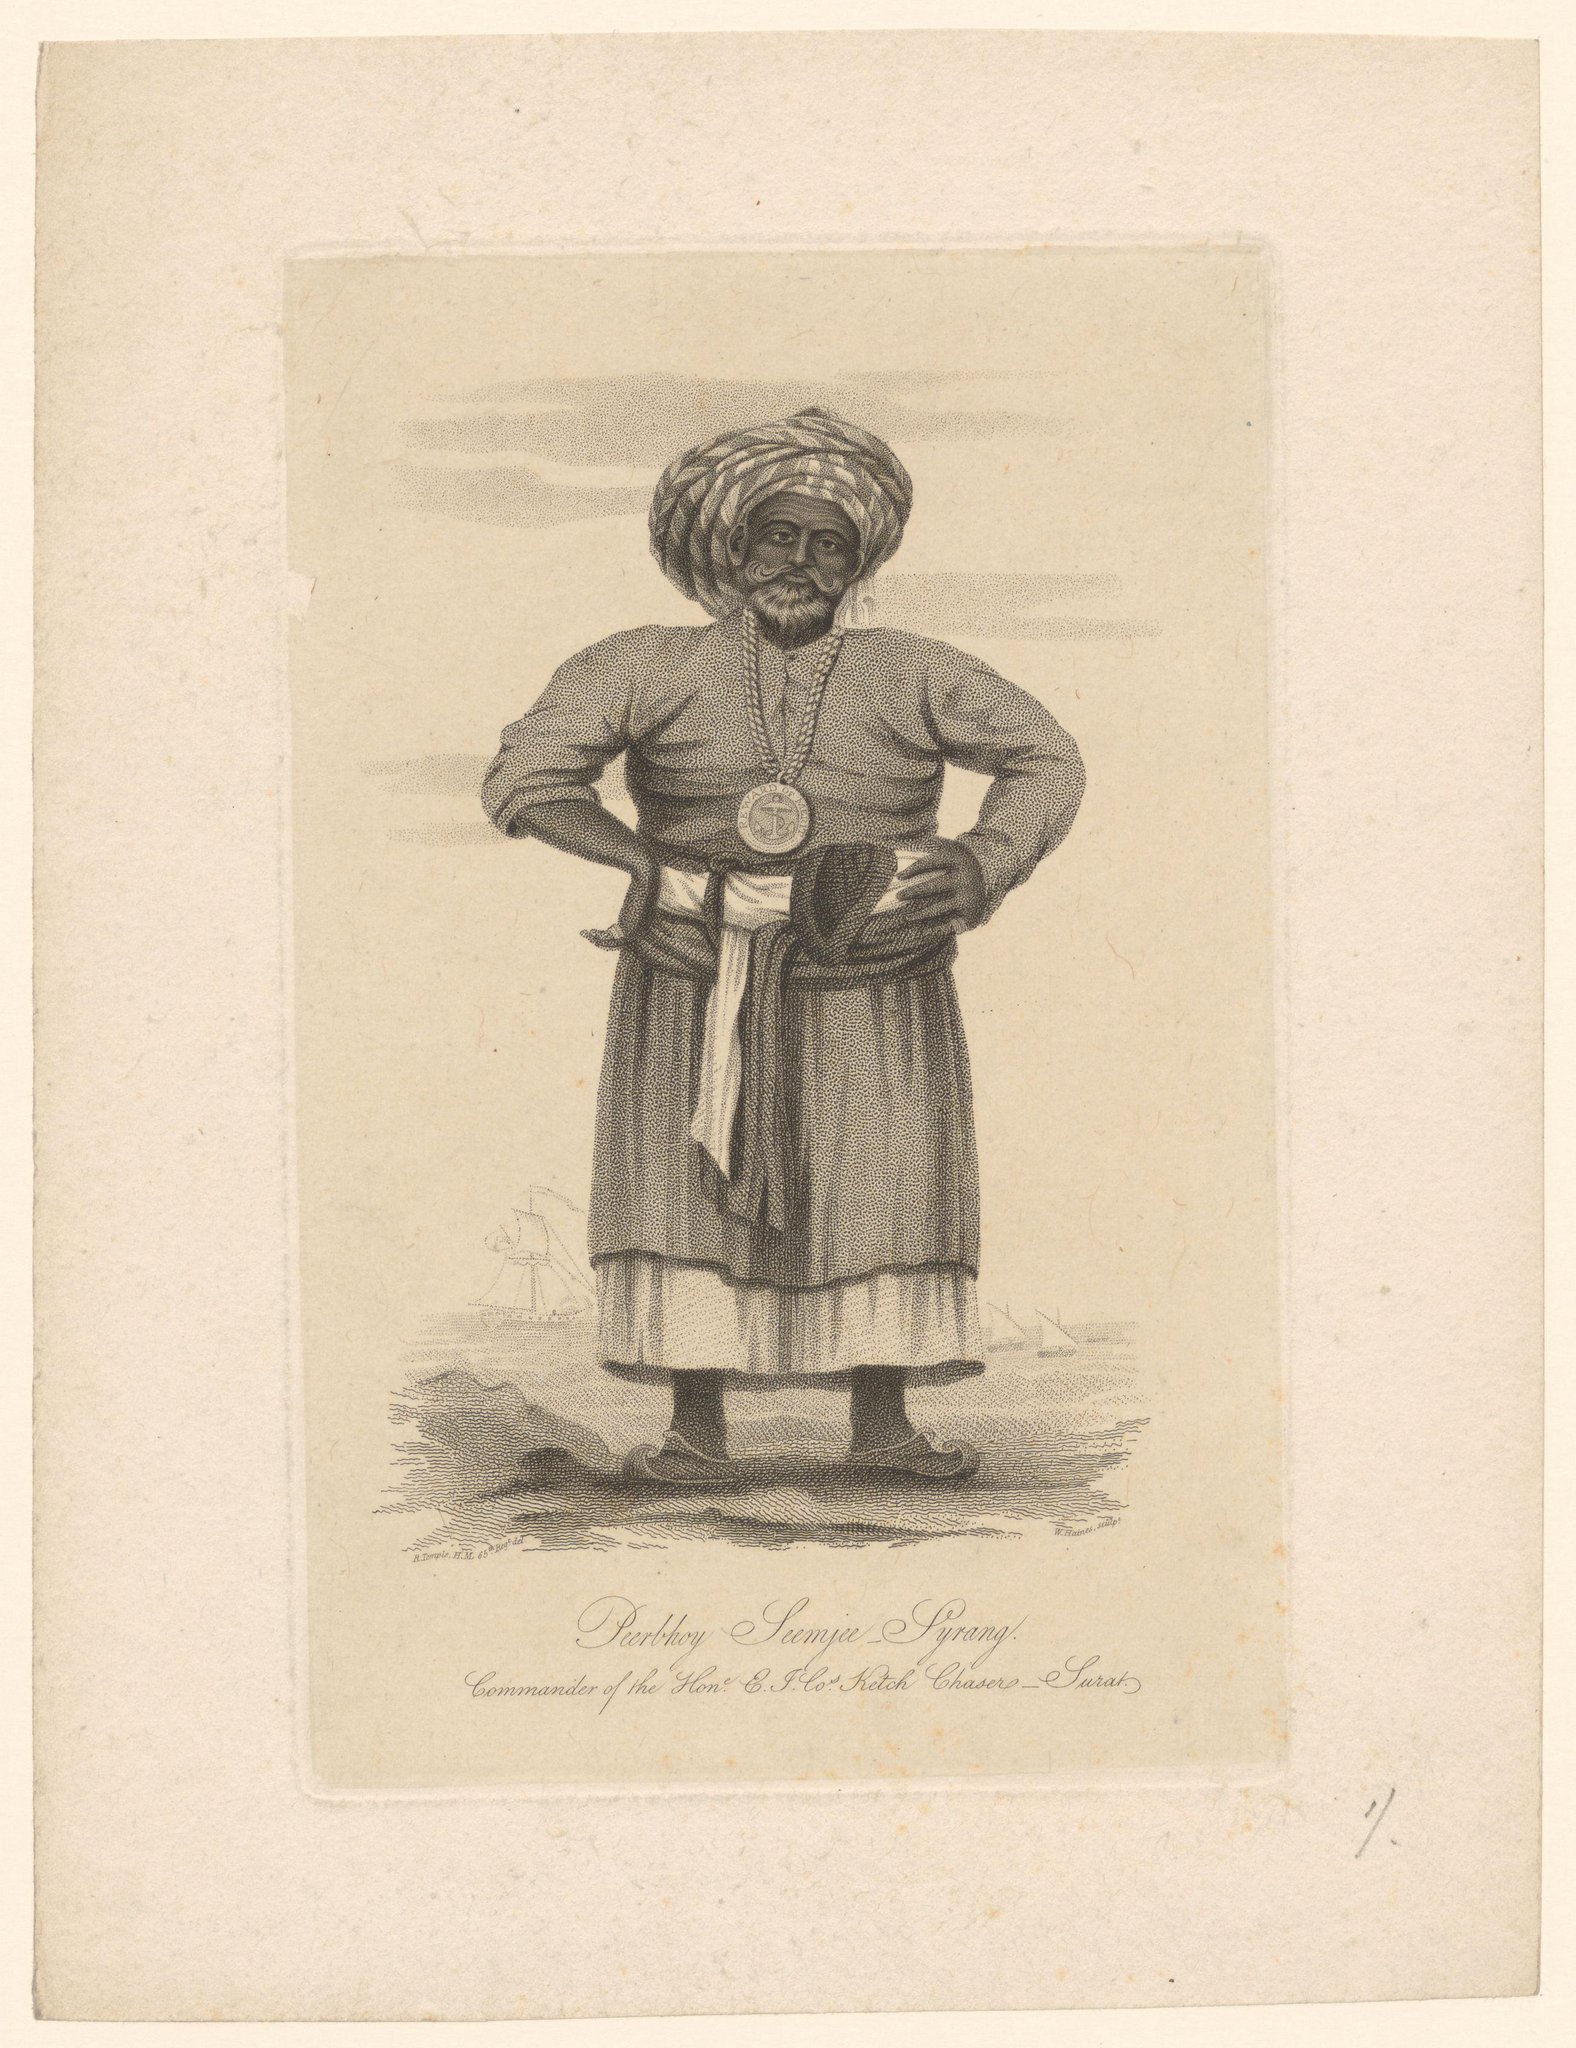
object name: print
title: Portret van Peerboy Seemjee Syrang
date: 1810-1820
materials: paper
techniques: etching, roulette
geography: great britain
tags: commander-in-chief, general, marshal, historical persons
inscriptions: collector's mark: Lugt 2228